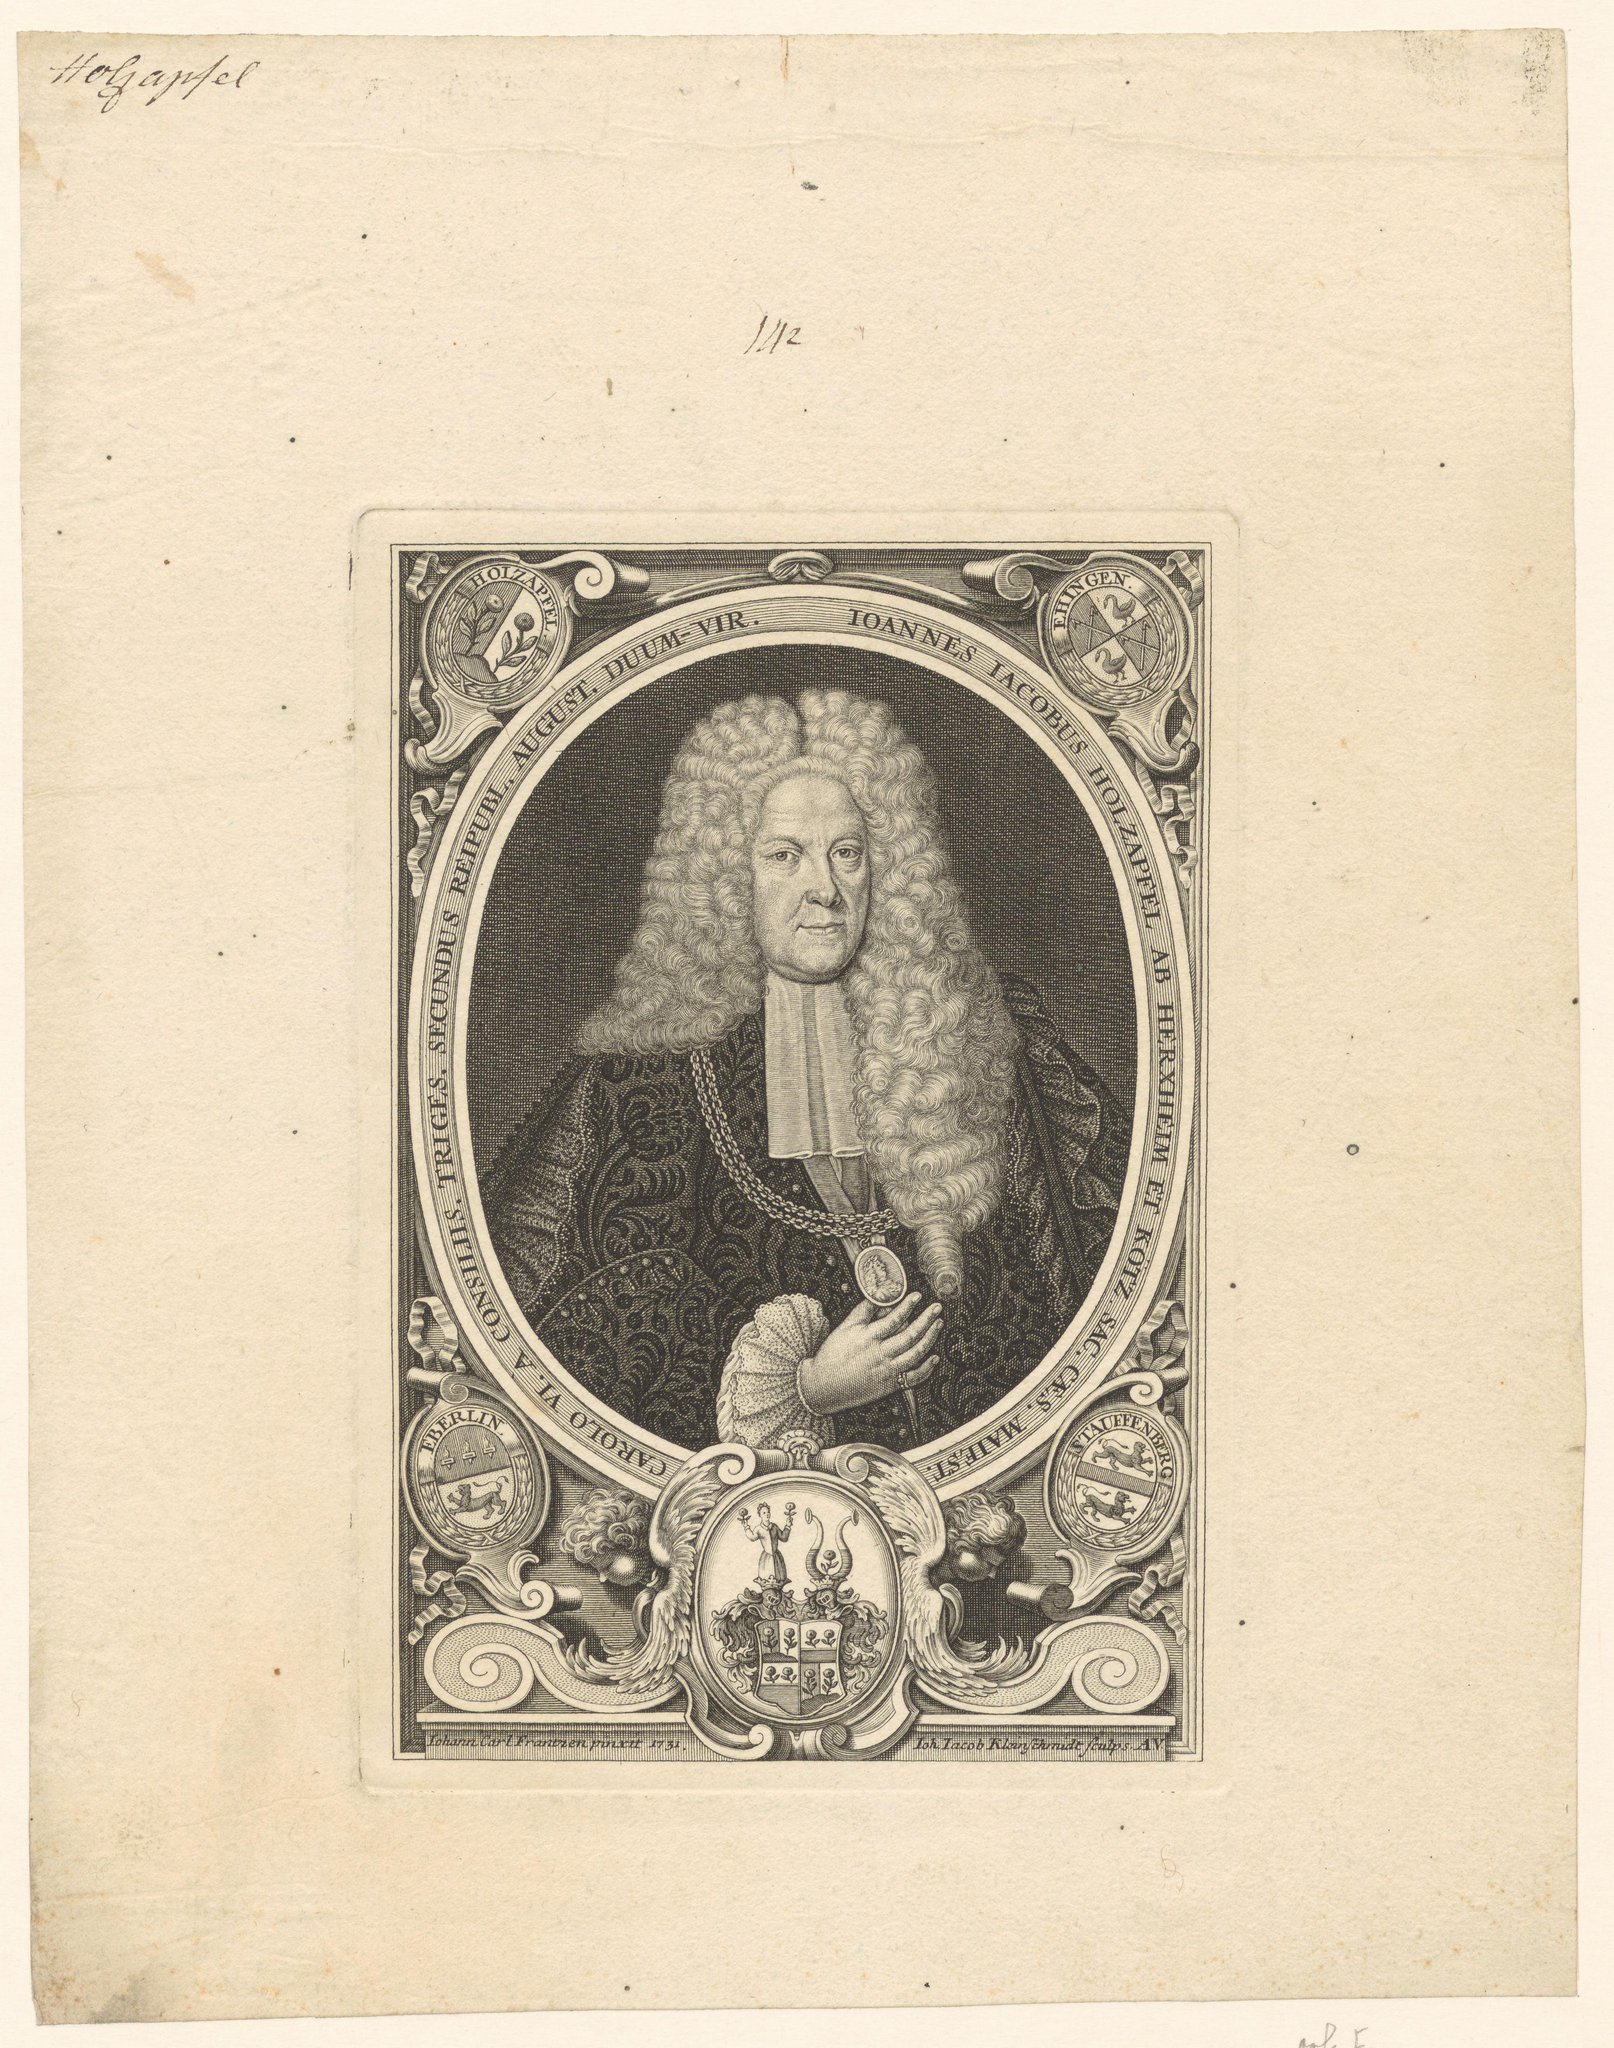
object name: print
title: Portret van Johann Jacob Holzapfel von Herxheim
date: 1731-1772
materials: paper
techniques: engraving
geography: augsburg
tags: coat of arms (as symbol of the state, etc.), official; civil servant; functionary (in general), historical persons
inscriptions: collector's mark: Lugt 2228